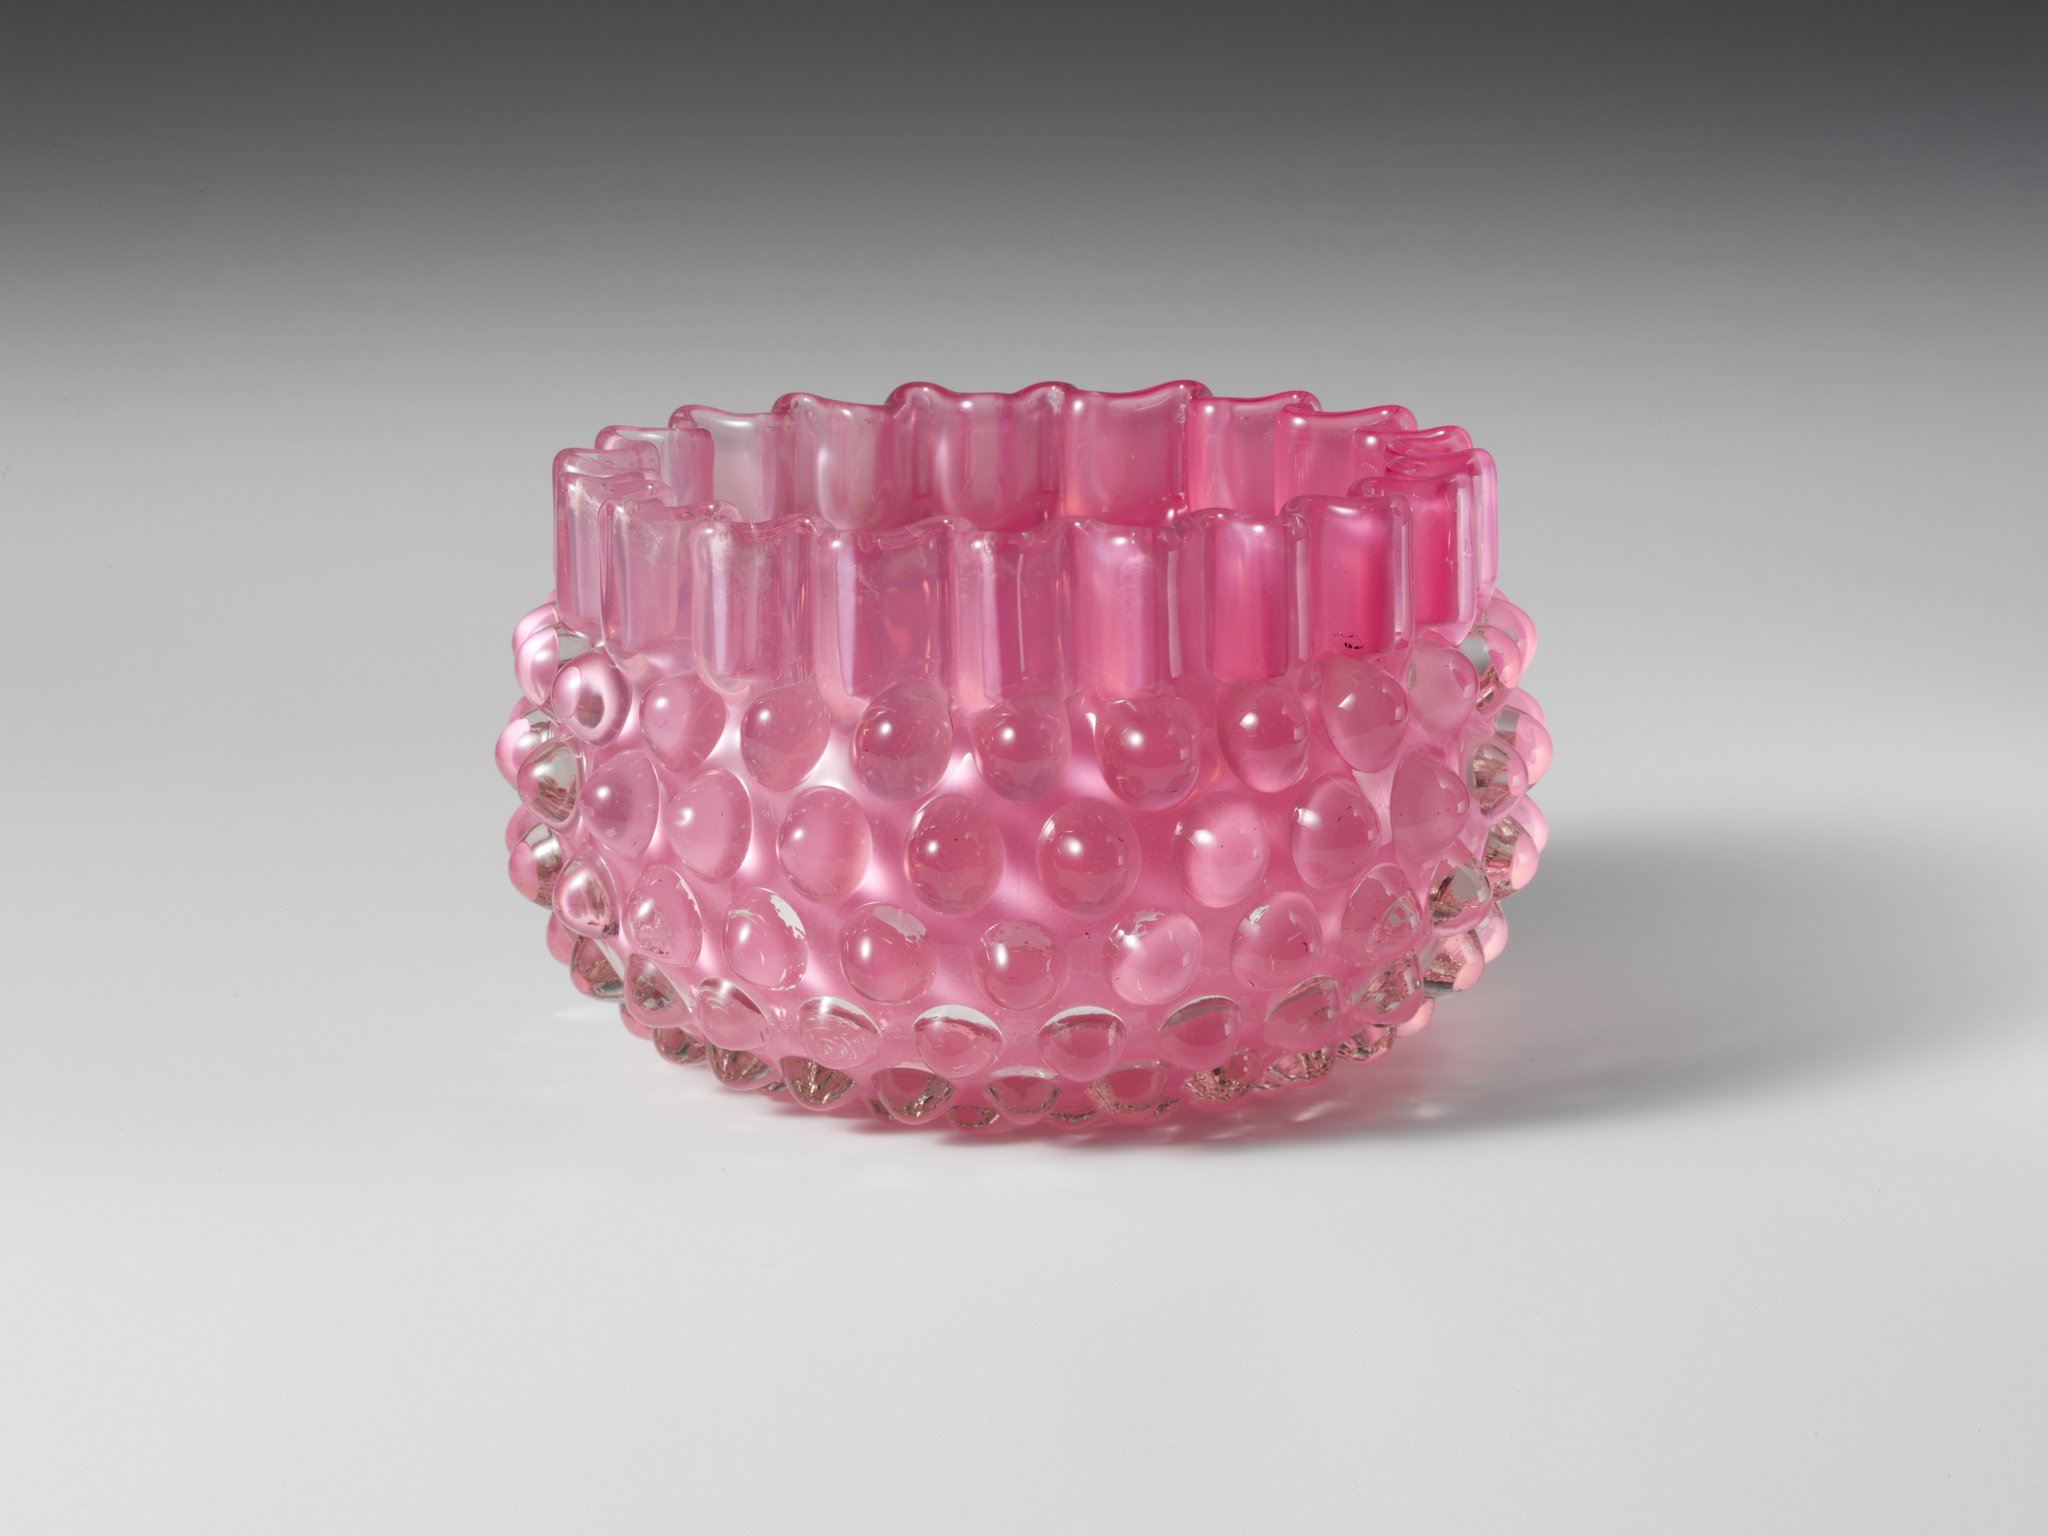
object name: finger bowl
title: Hobnail Finger Bowl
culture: american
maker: hobbs, brockunier and company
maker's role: maker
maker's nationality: american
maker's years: 1863-1891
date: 1886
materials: glass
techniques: pressed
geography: united states